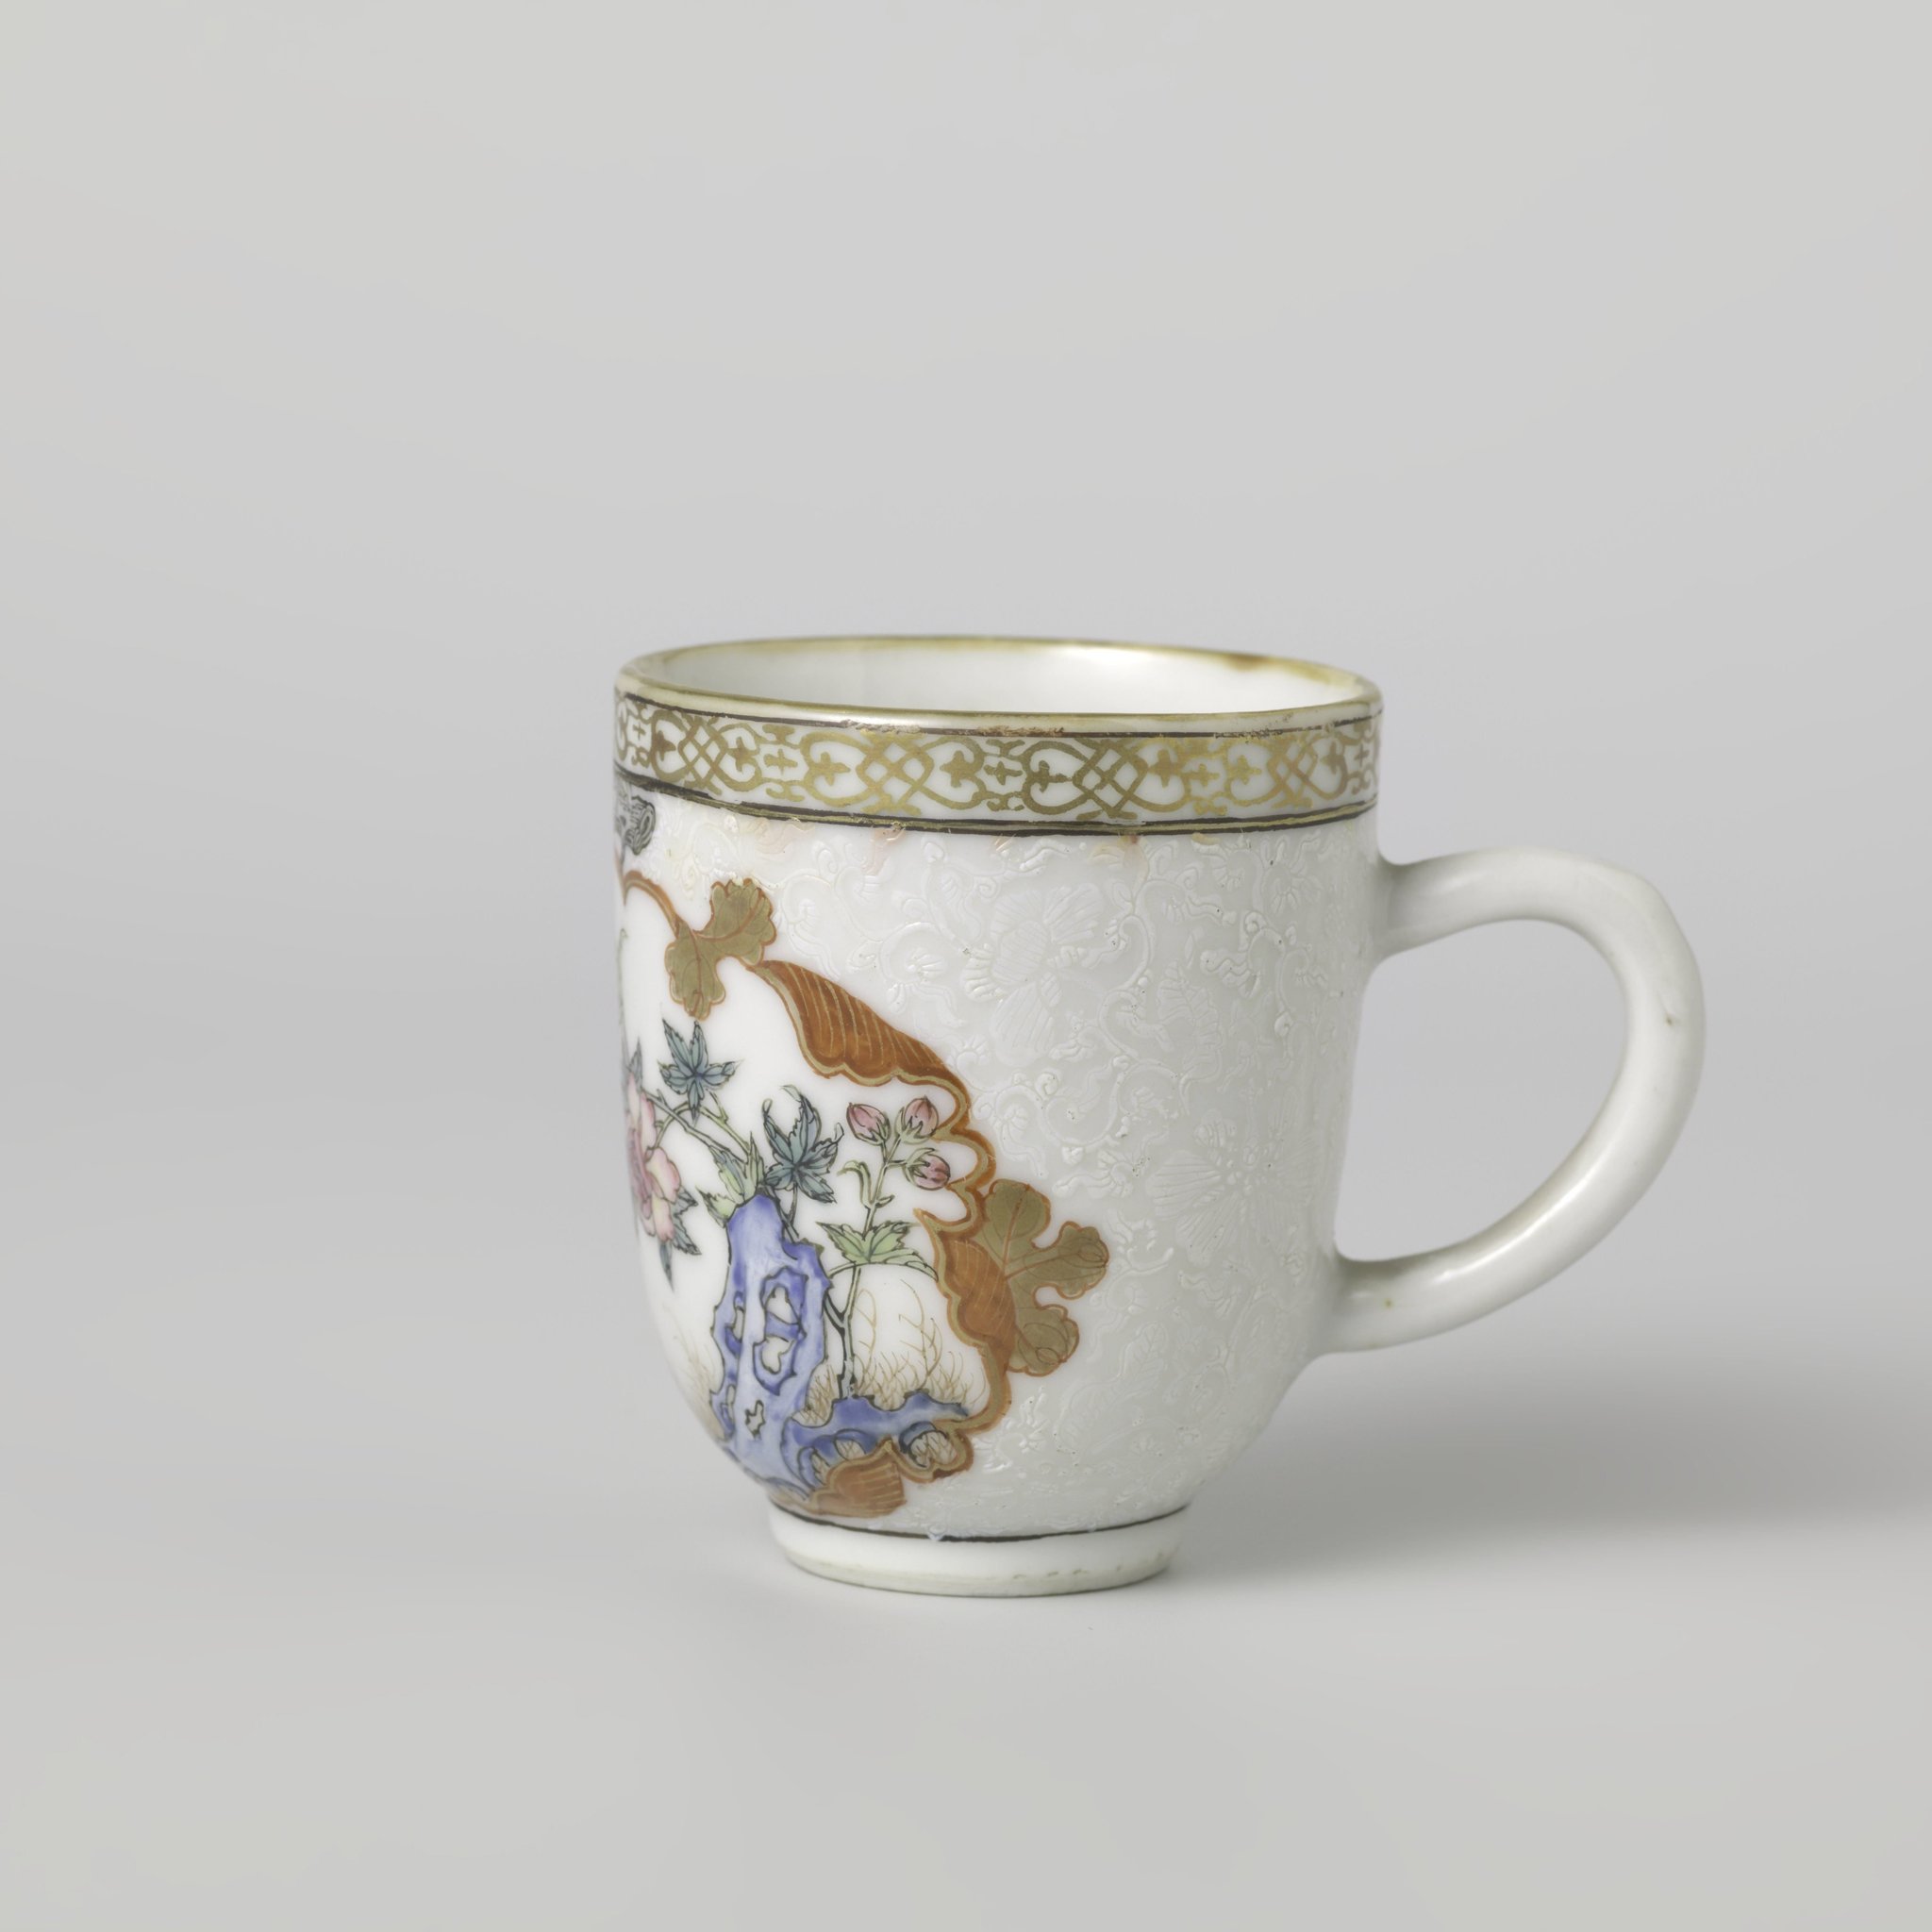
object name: oorkop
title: Cup with handle with a crane near a peony plant and rock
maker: Anonymous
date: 1725-1749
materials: glaze, gold, paint, porcelain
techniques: firing, gilding, turning, vitrification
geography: china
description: Gedecoreerd in emails, goud en bianco sopra bianco met vogels en bloeiende planten.